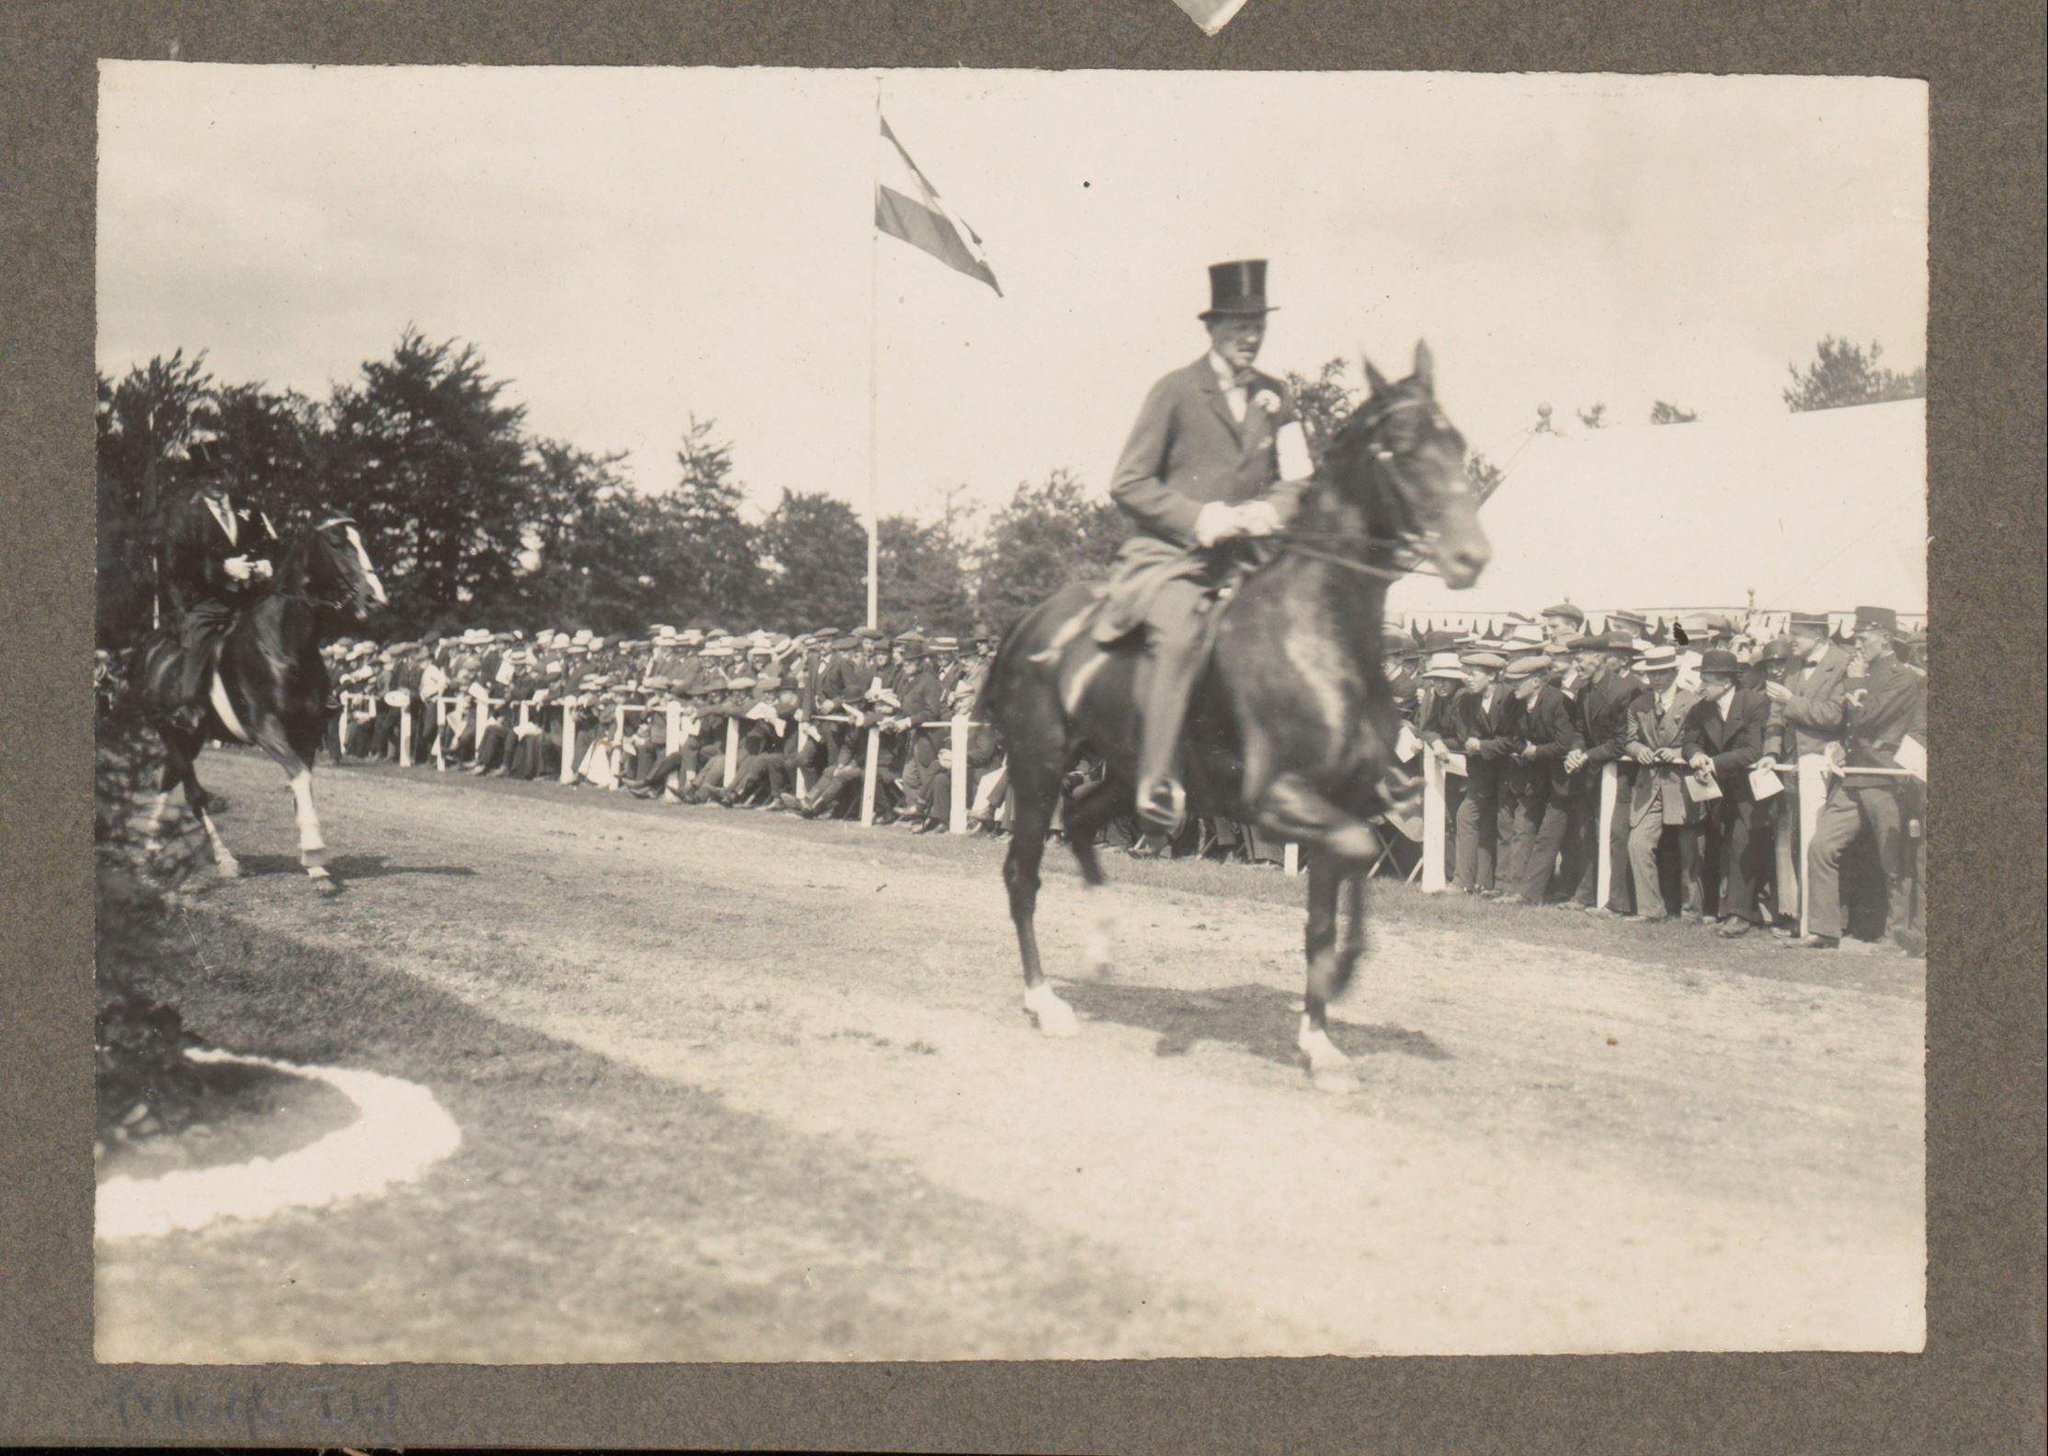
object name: album leaf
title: Ruitertafereel op Koninklijke Houtvesterij Het Loo: ruiters op een grasveld bij publiek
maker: Anonymous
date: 1900-1925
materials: photographic support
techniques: gelatin silver print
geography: het loo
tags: riding a horse, ass, or mule; rider, horseman, crowd, mob, hunting, chase, hunting-ground, race-track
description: Onderdeel van Fotoalbum van de heer Brams, opperhoutvester van koningin Wilhelmina op Koninklijke Houtvesterij Het Loo.